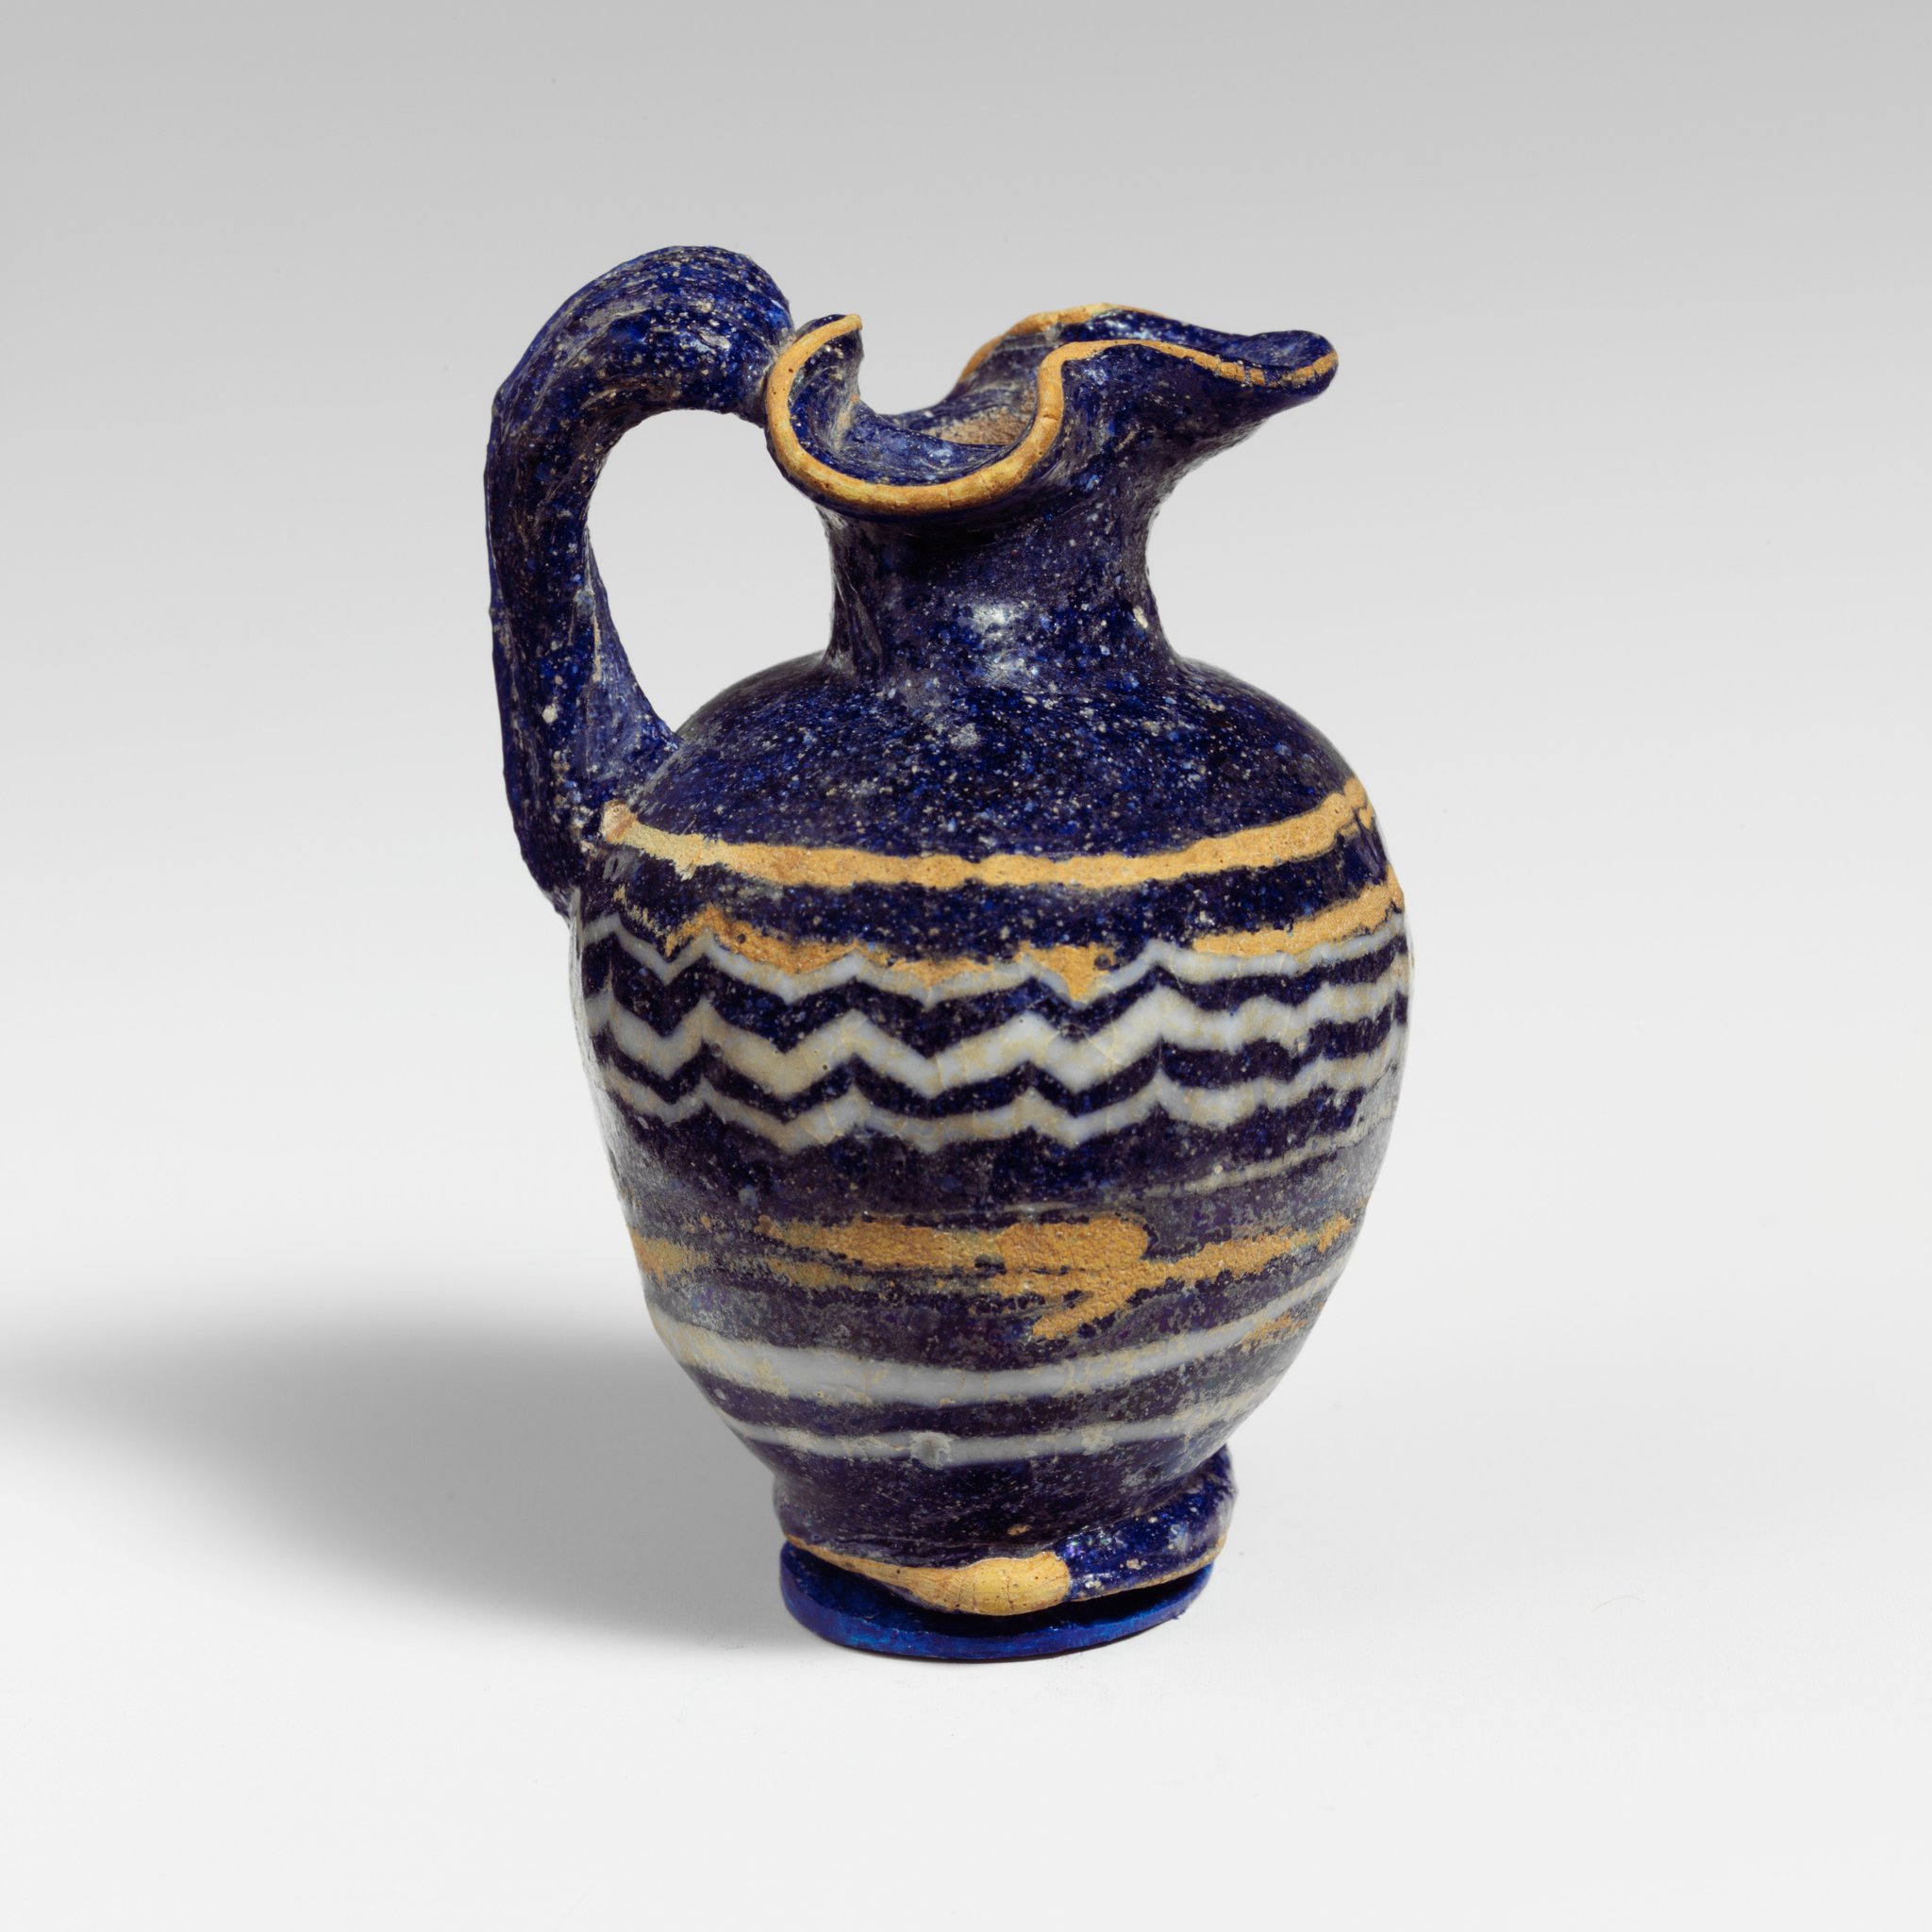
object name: oinochoe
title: Glass oinochoe (perfume jug)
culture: greek, eastern mediterranean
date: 400-201 BCE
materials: glass